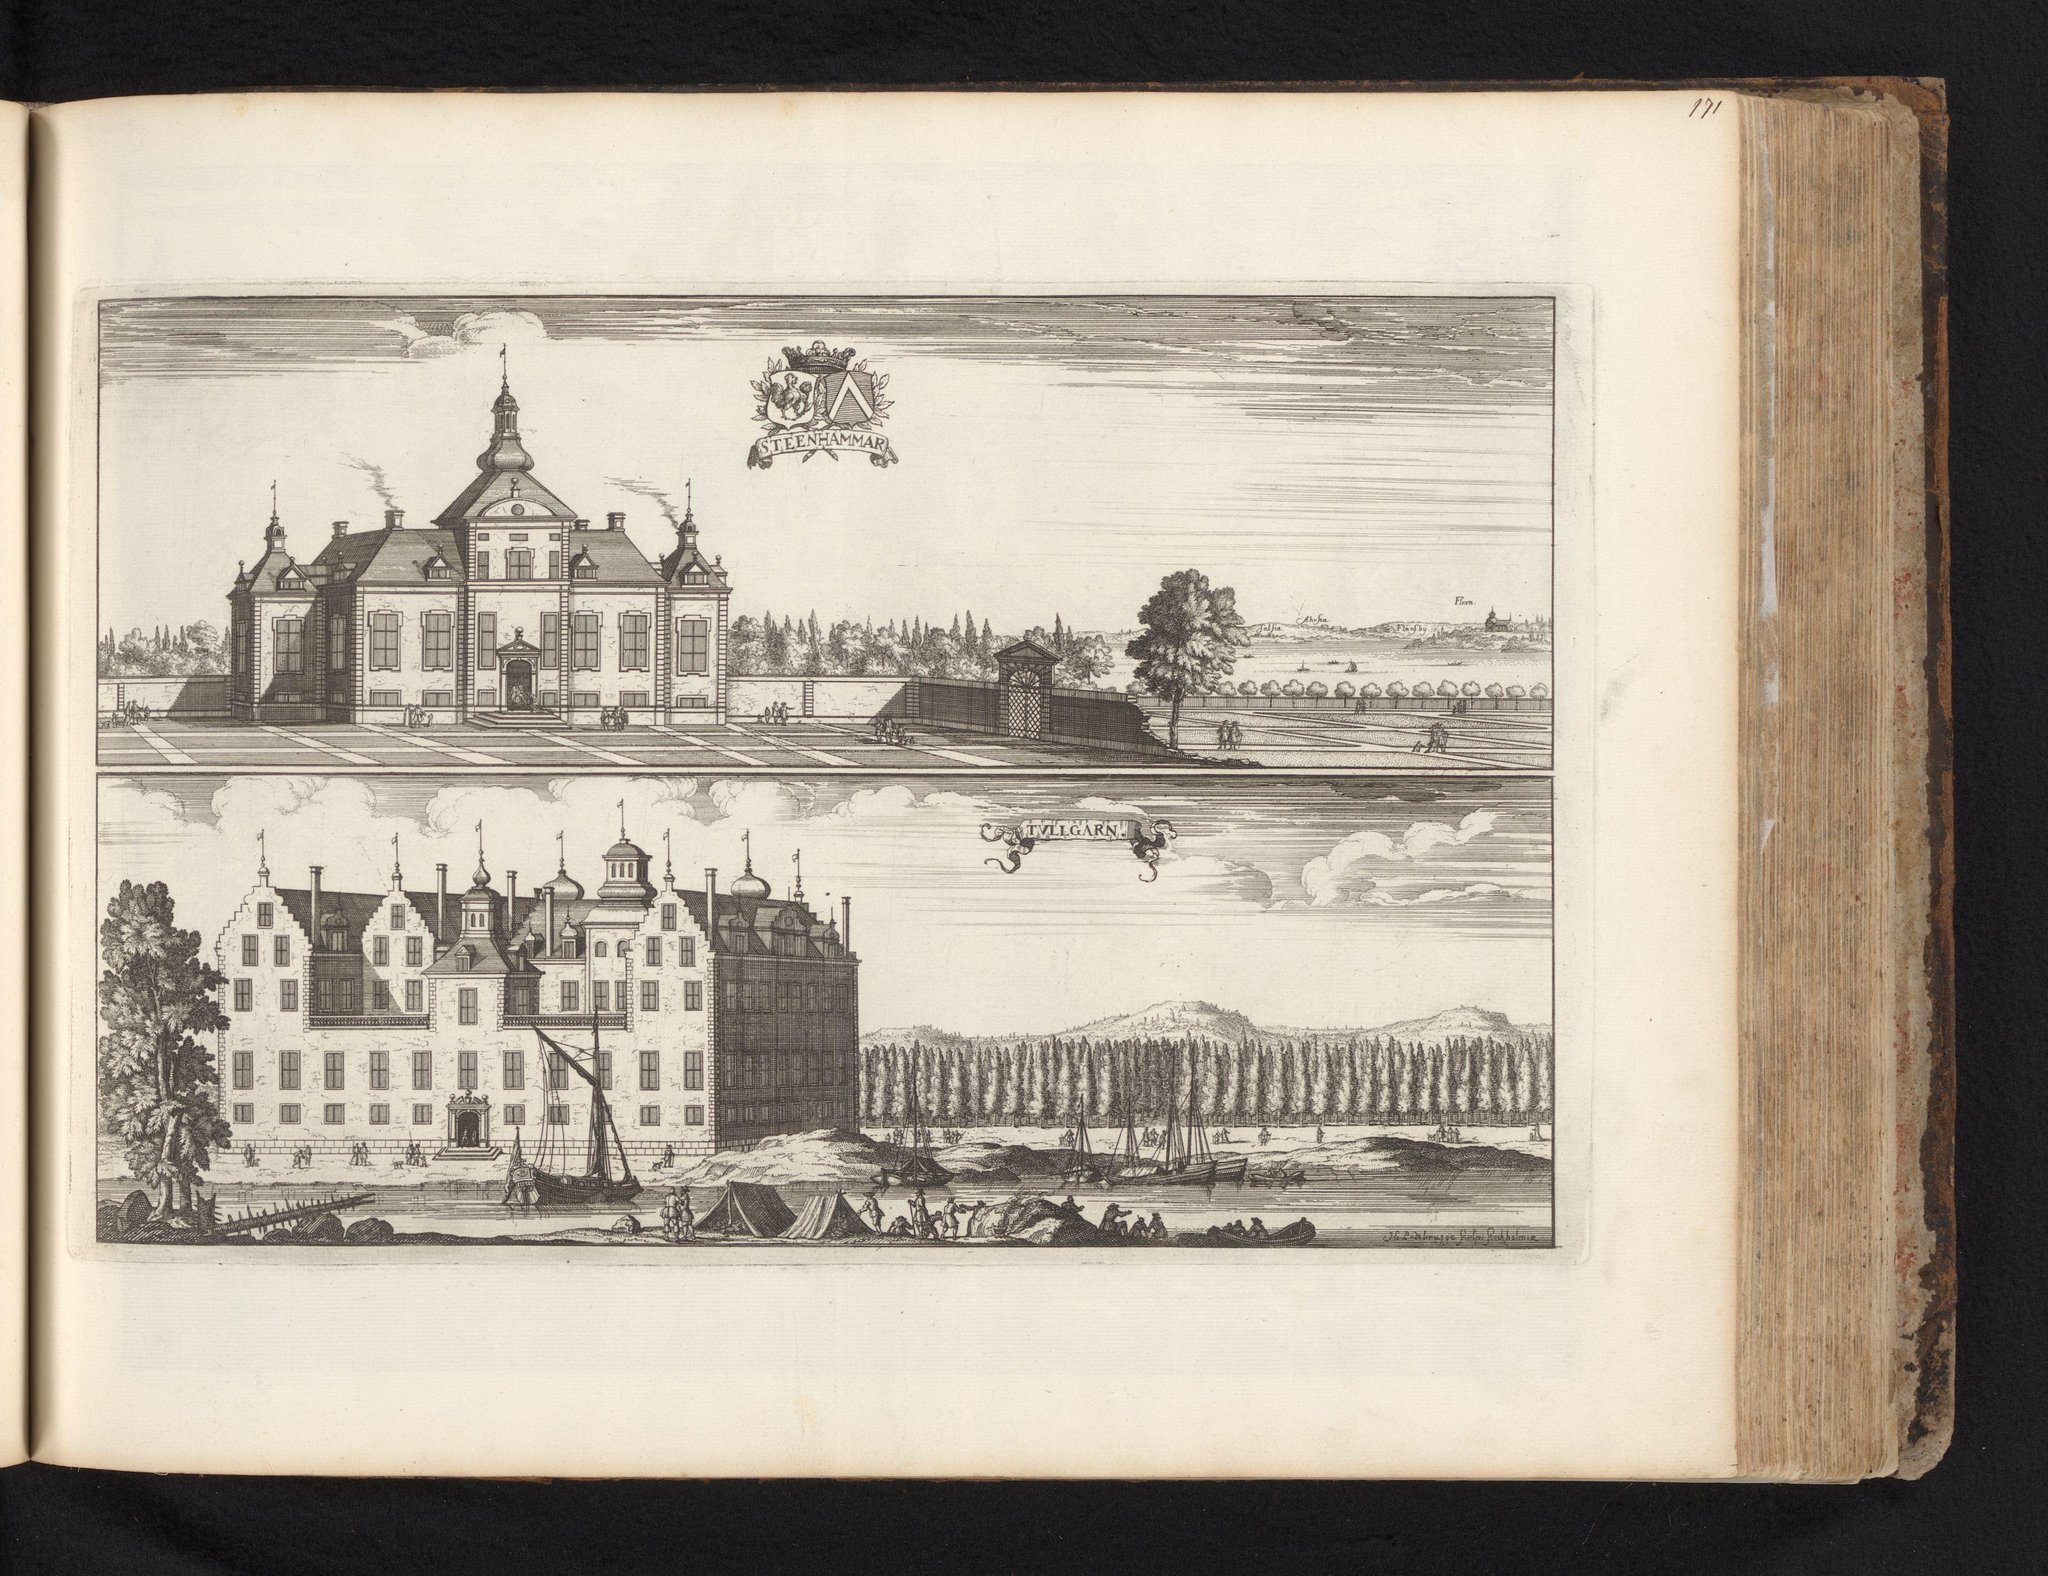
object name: album leaf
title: Suecia Antiqua et Hodierna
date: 1686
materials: paper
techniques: etching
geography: stockholm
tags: housing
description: Kungliga Biblioteket, 'Suecia': http://www.kb.se/samlingarna/Kartor-bilder/Suecia-antiqua/ (geraadpleegd november 2016).